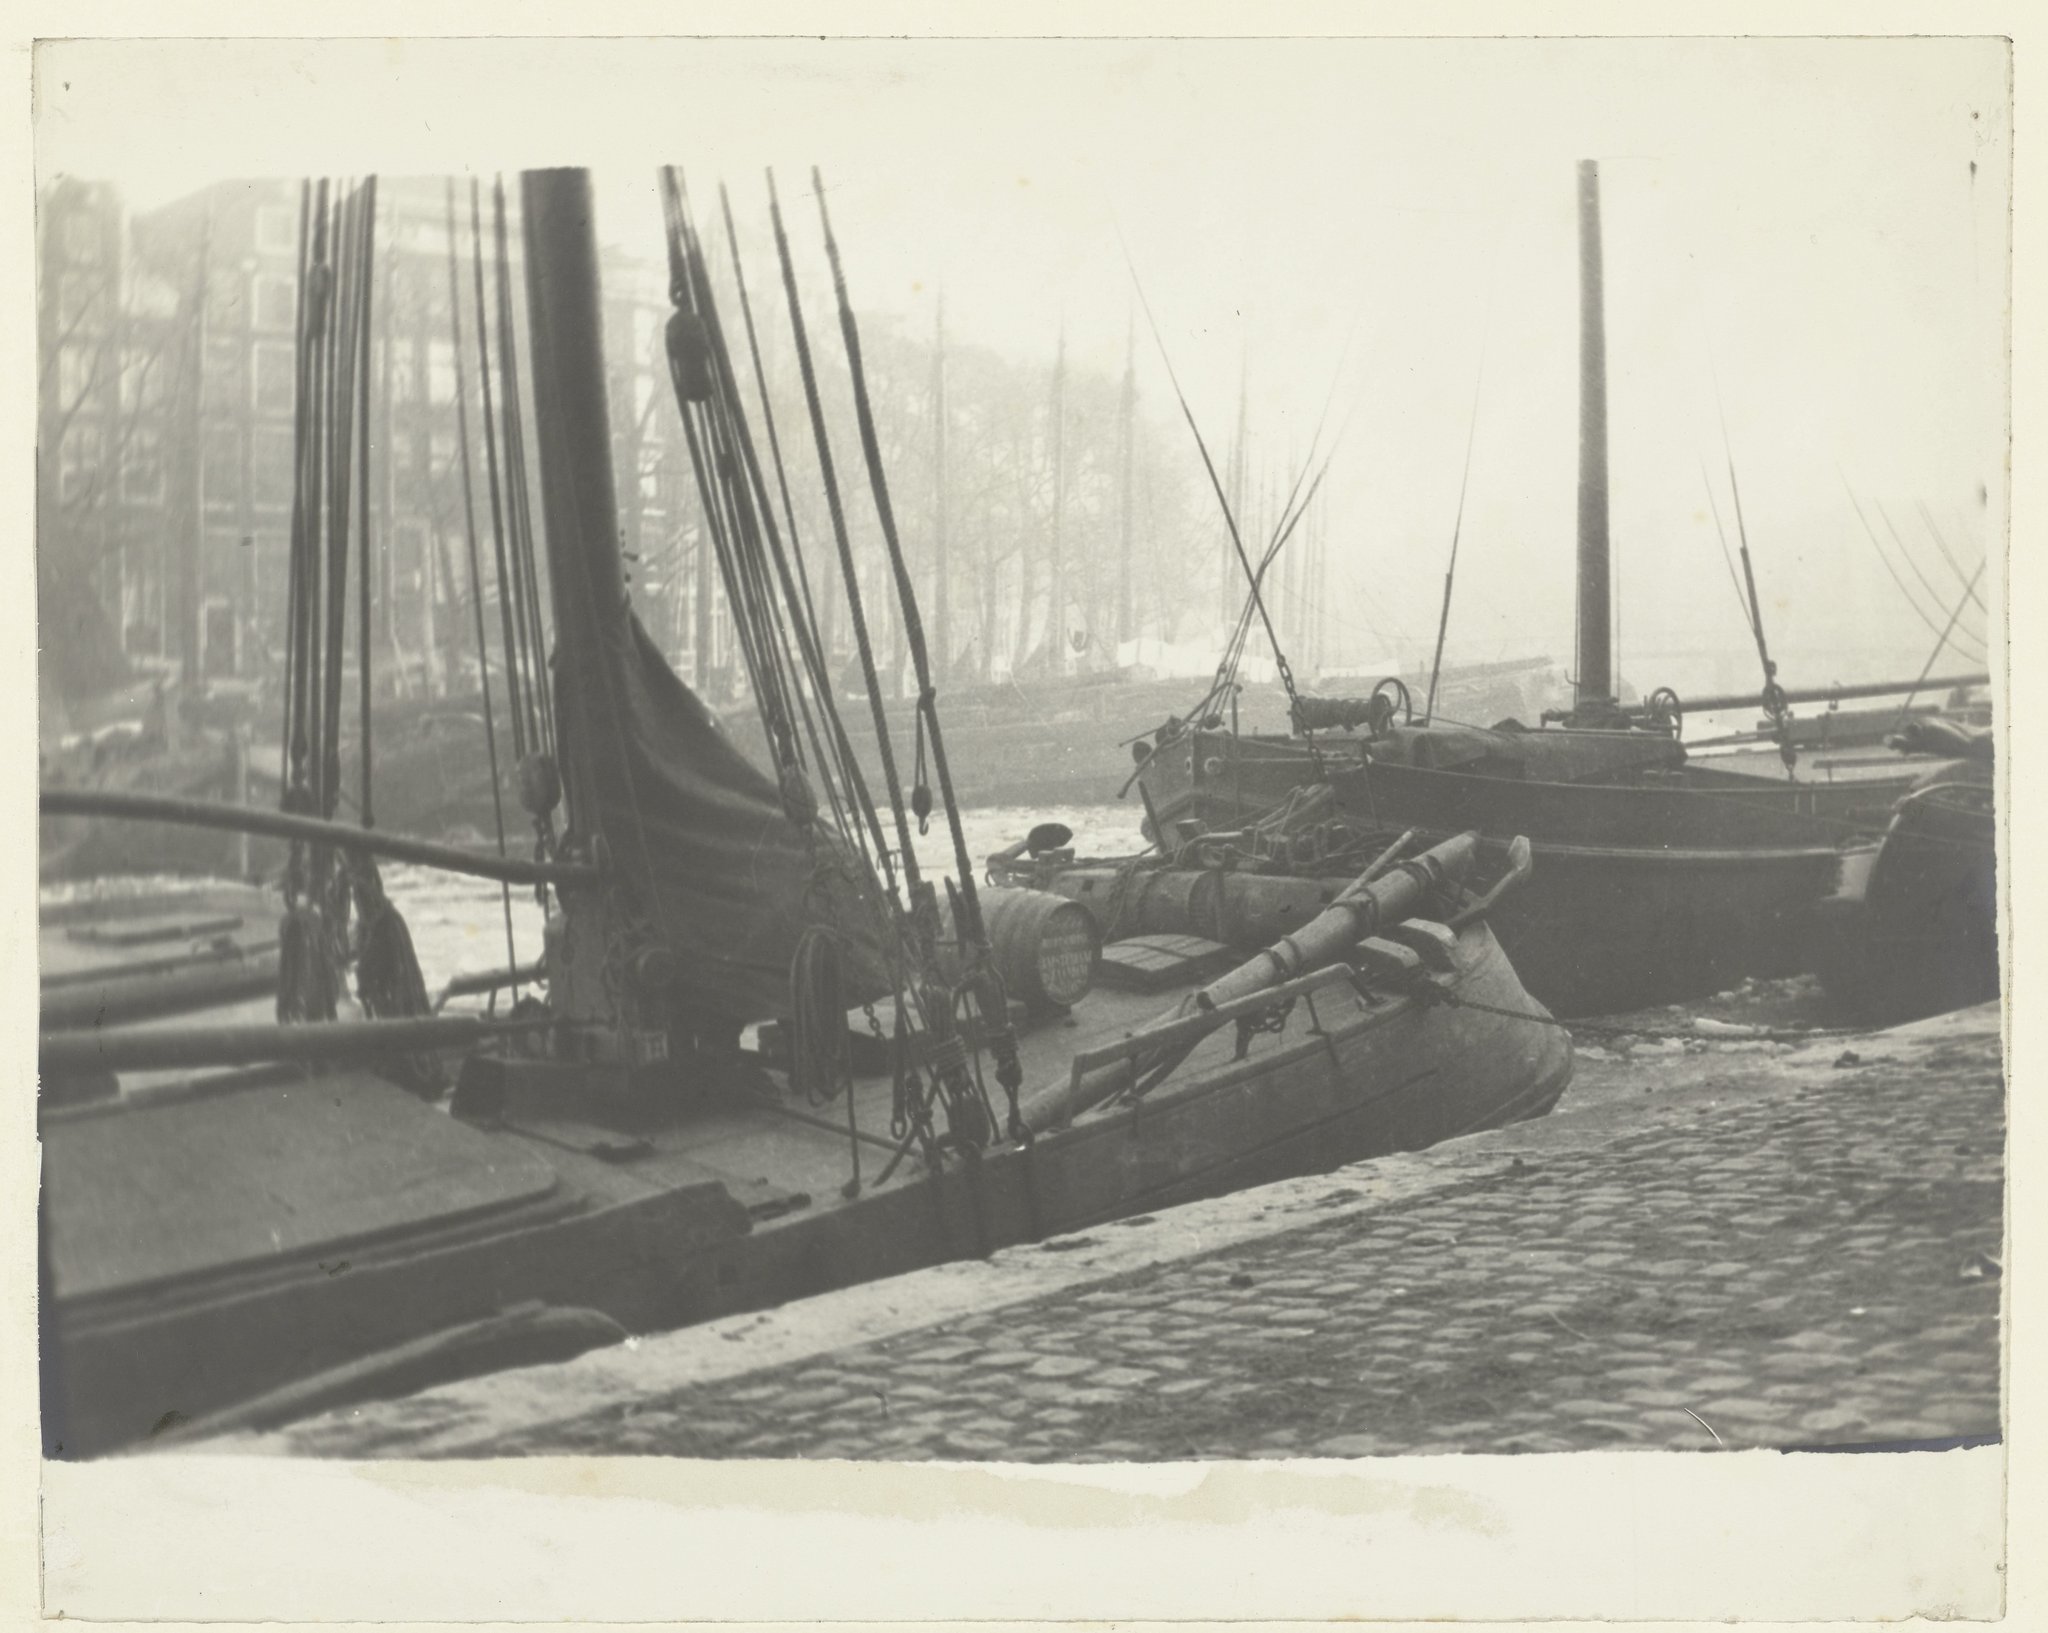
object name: photograph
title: Gezicht op de Waalseilandsgracht gezien naar de Binnenkant in Amsterdam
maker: george hendrik breitner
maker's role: draughtsman, painter, print maker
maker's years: 1857-1923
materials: cardboard, paper, photographic support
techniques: gelatin silver print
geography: amsterdam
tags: ships (in general), canals, waters (in city), quay, amsterdam